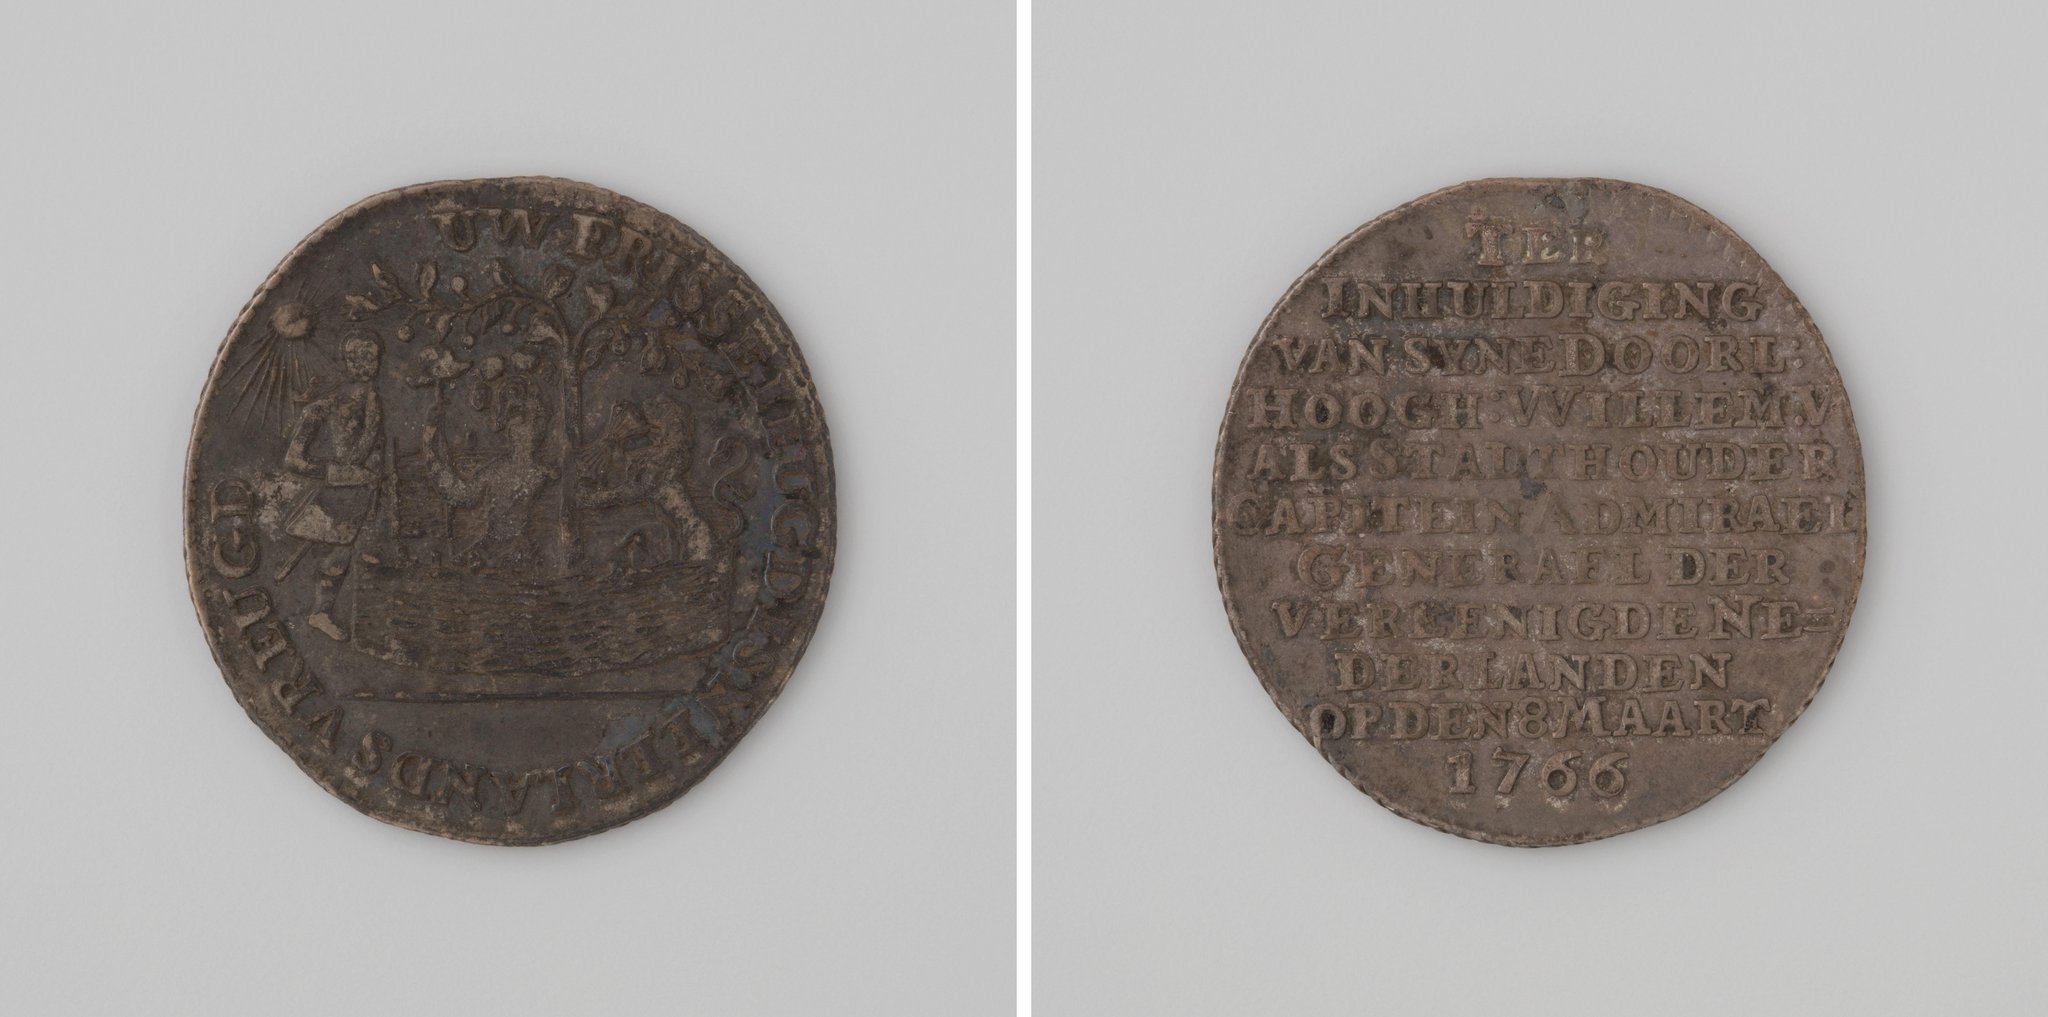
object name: history medal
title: Inhuldiging van Willem V, prins van Oranje-Nassau, als erfelijk stadhouder van de Nederlanden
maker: Anonymous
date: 1766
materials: silver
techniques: striking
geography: netherlands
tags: the hague, william v (prince of orange)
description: Zilveren penning. Voorzijde: Nederlandse maagd met vrijheidshoed op speer en leeuw met pijlenbundel onder takken van oranjeboom in tuin, waarin Willem V binnen treedt binnen omschrift. Keerzijde: opschrift